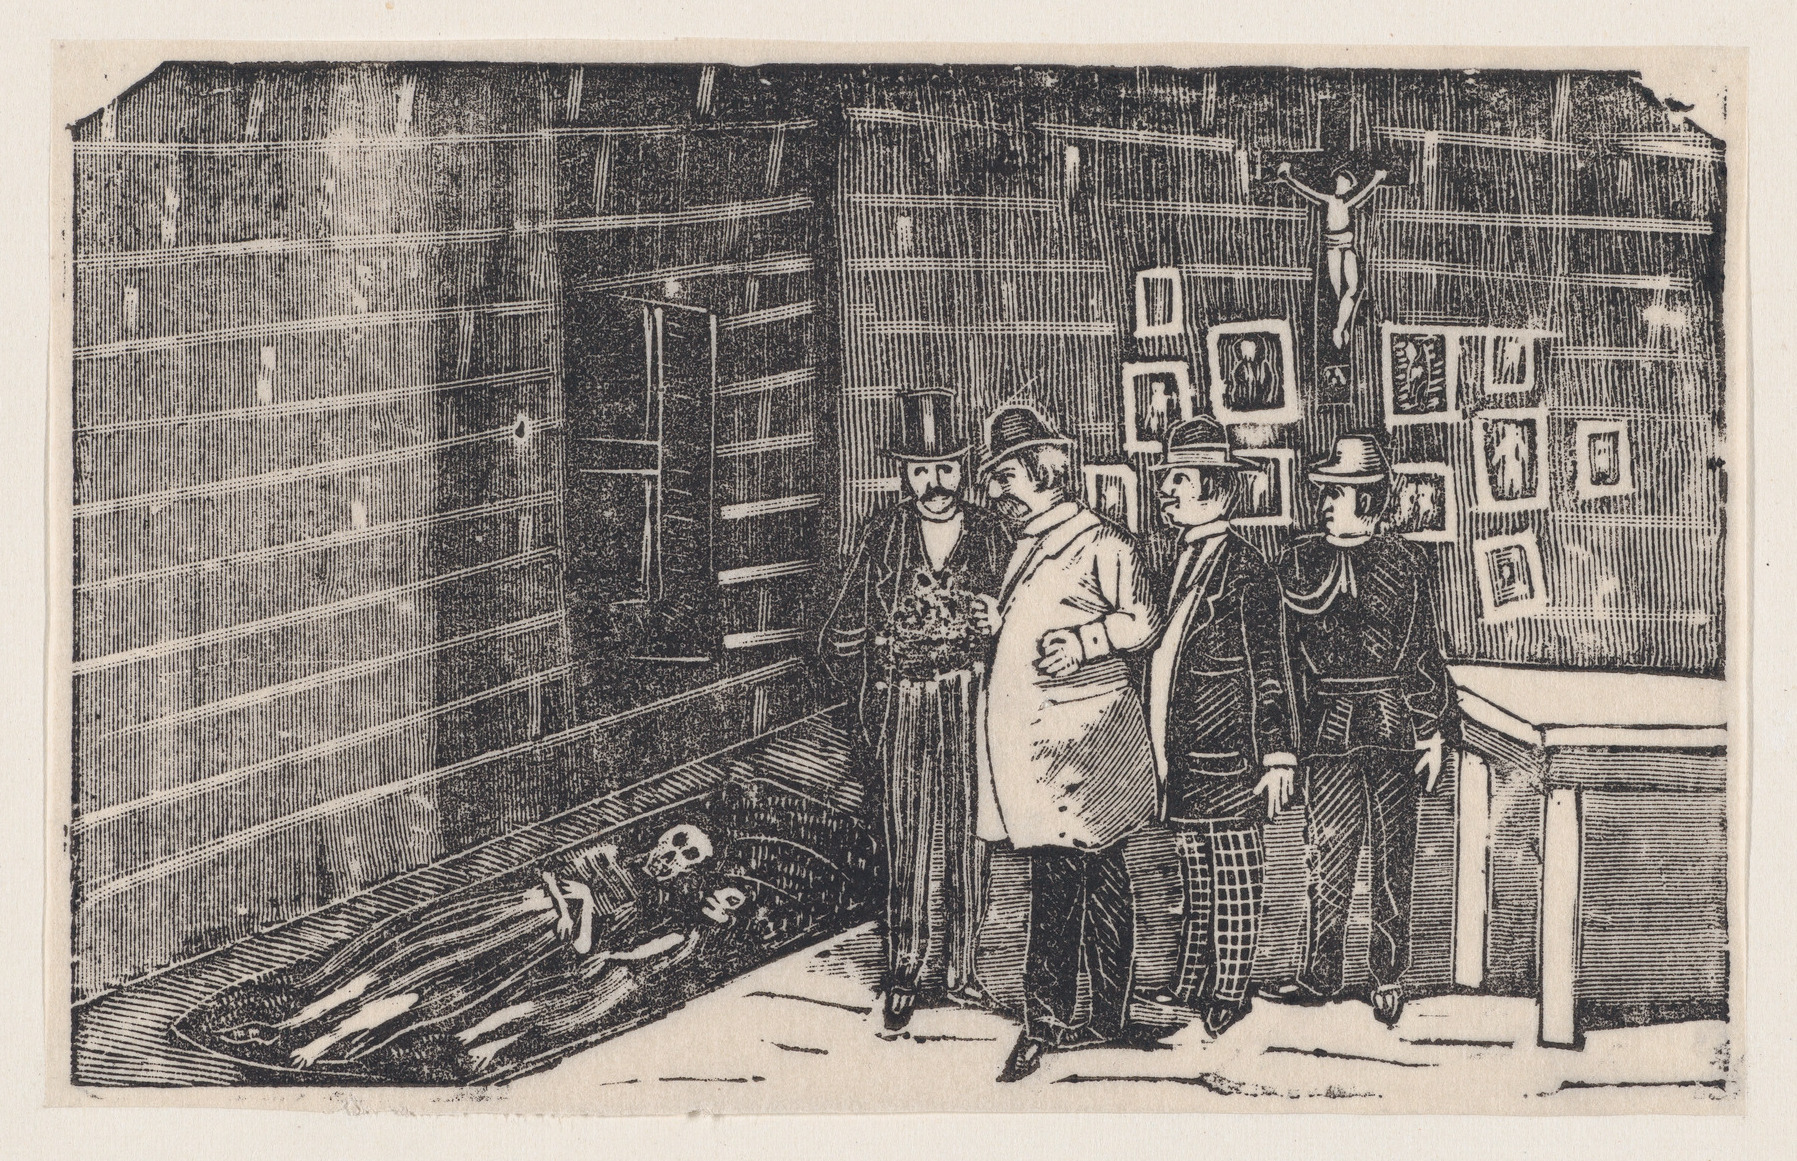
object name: print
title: Discovery of two bodies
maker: josé guadalupe posada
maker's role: artist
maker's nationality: mexican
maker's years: 1852-1913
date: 1880-1910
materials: metal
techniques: engraving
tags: skeletons,men